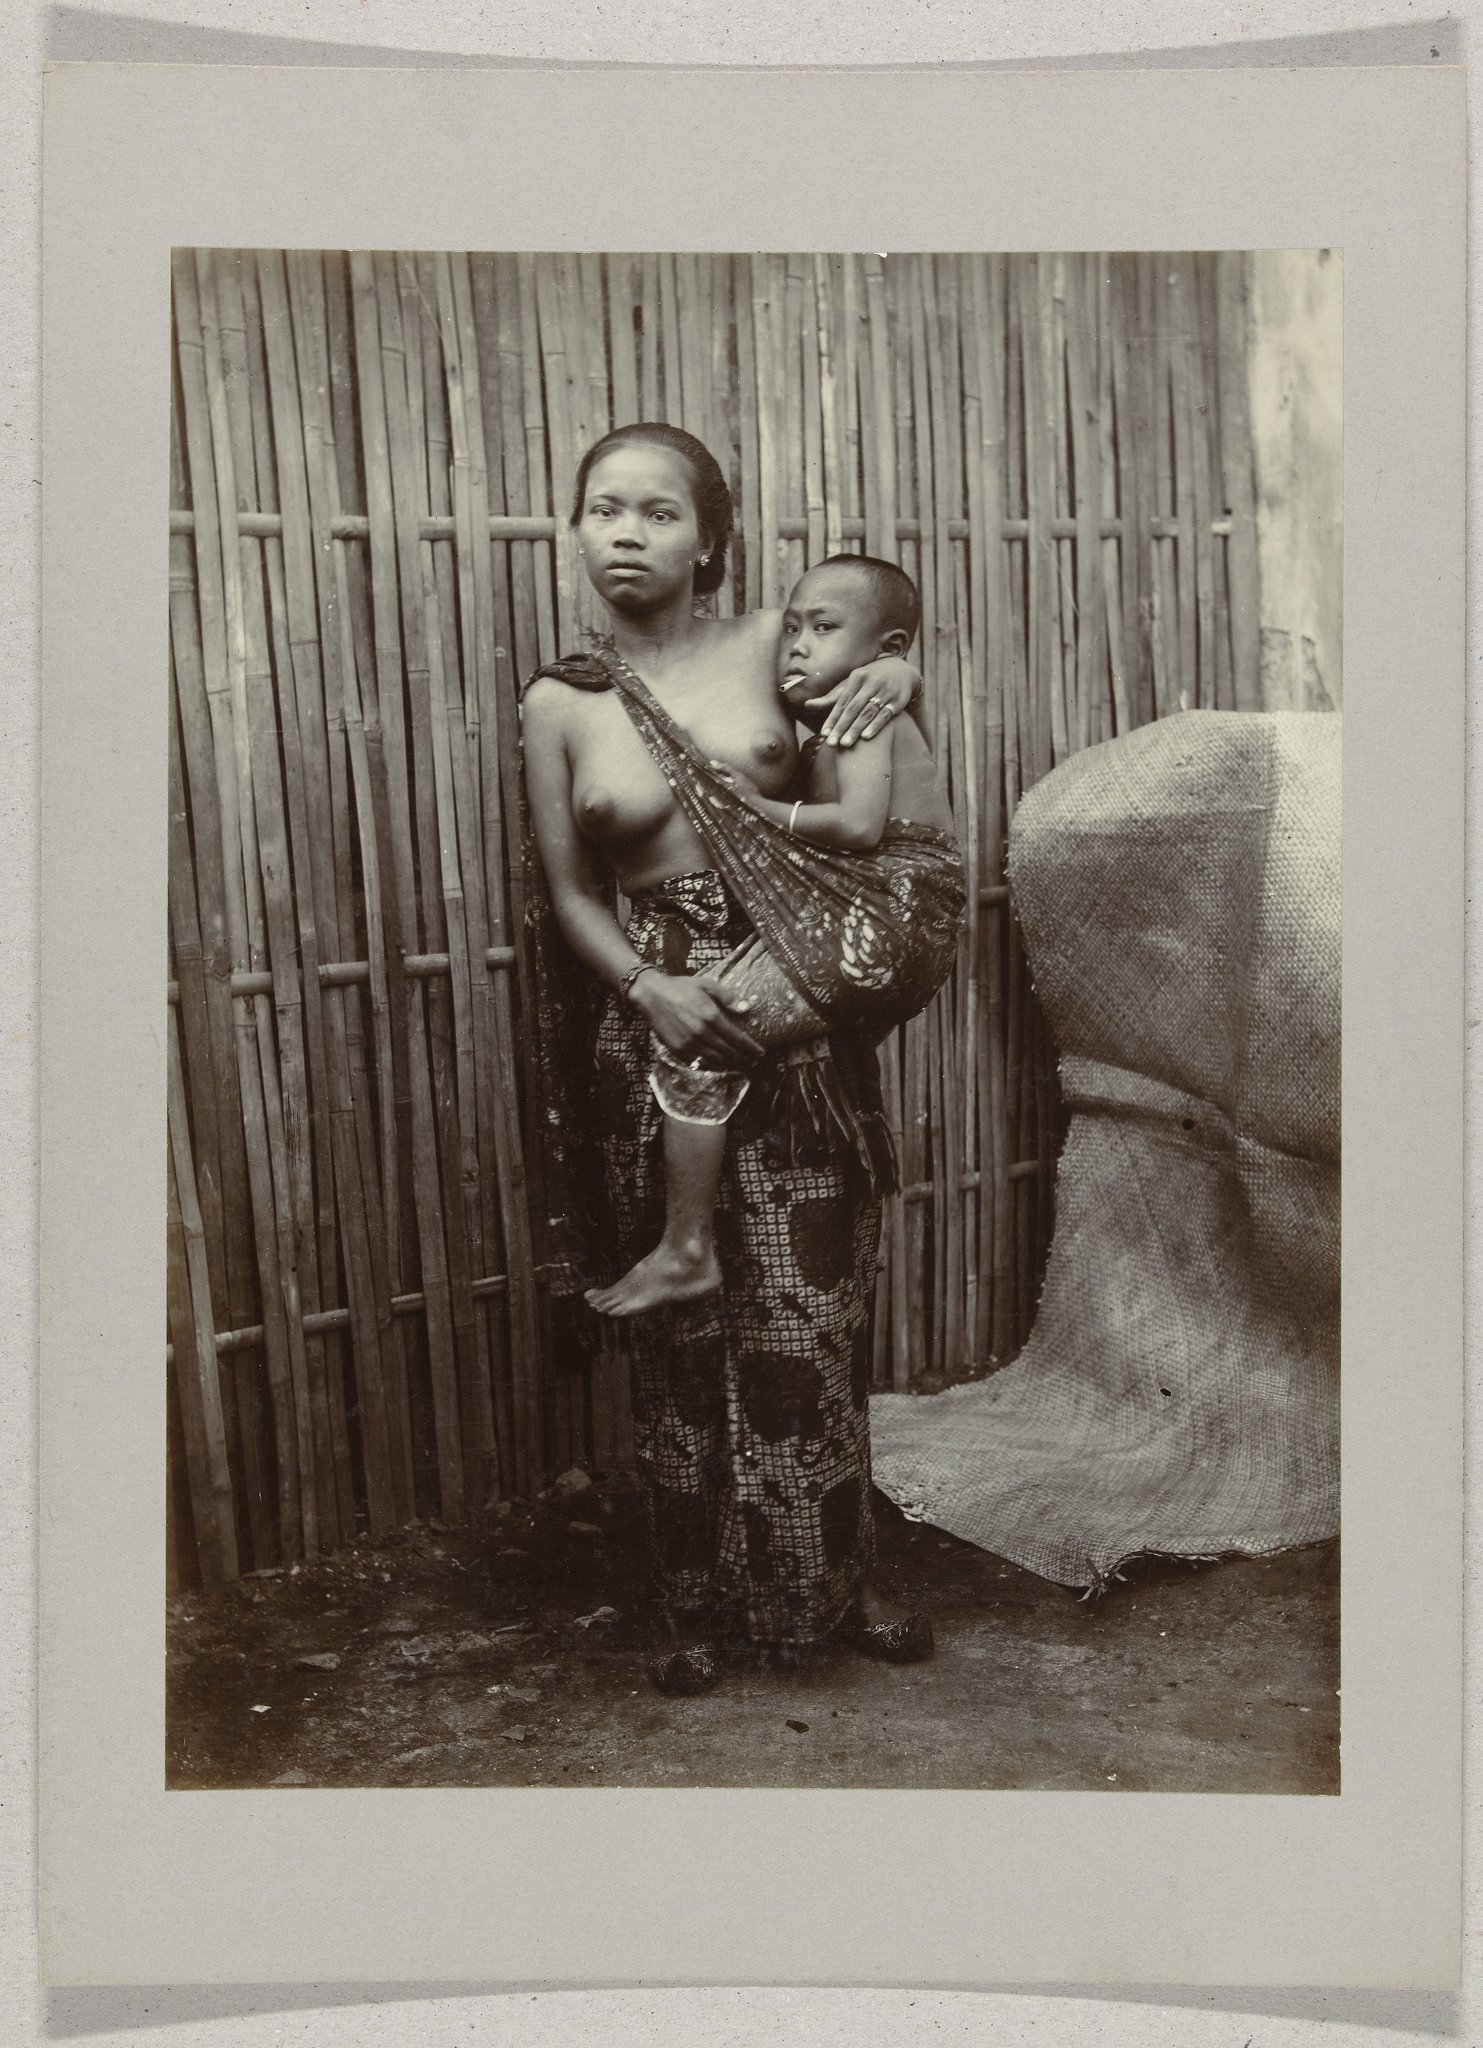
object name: photograph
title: Studioportret van een vrouw met een kind op haar heup in Nederlands-Indië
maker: Anonymous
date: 1895-1915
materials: cardboard, paper, photographic support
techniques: gelatin silver print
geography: dutch east indies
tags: indonesia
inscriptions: number: ‘33’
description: Portret van een vrouw met een kind op haar heup, gemaakt in een studio (?), Nederlands-Indië